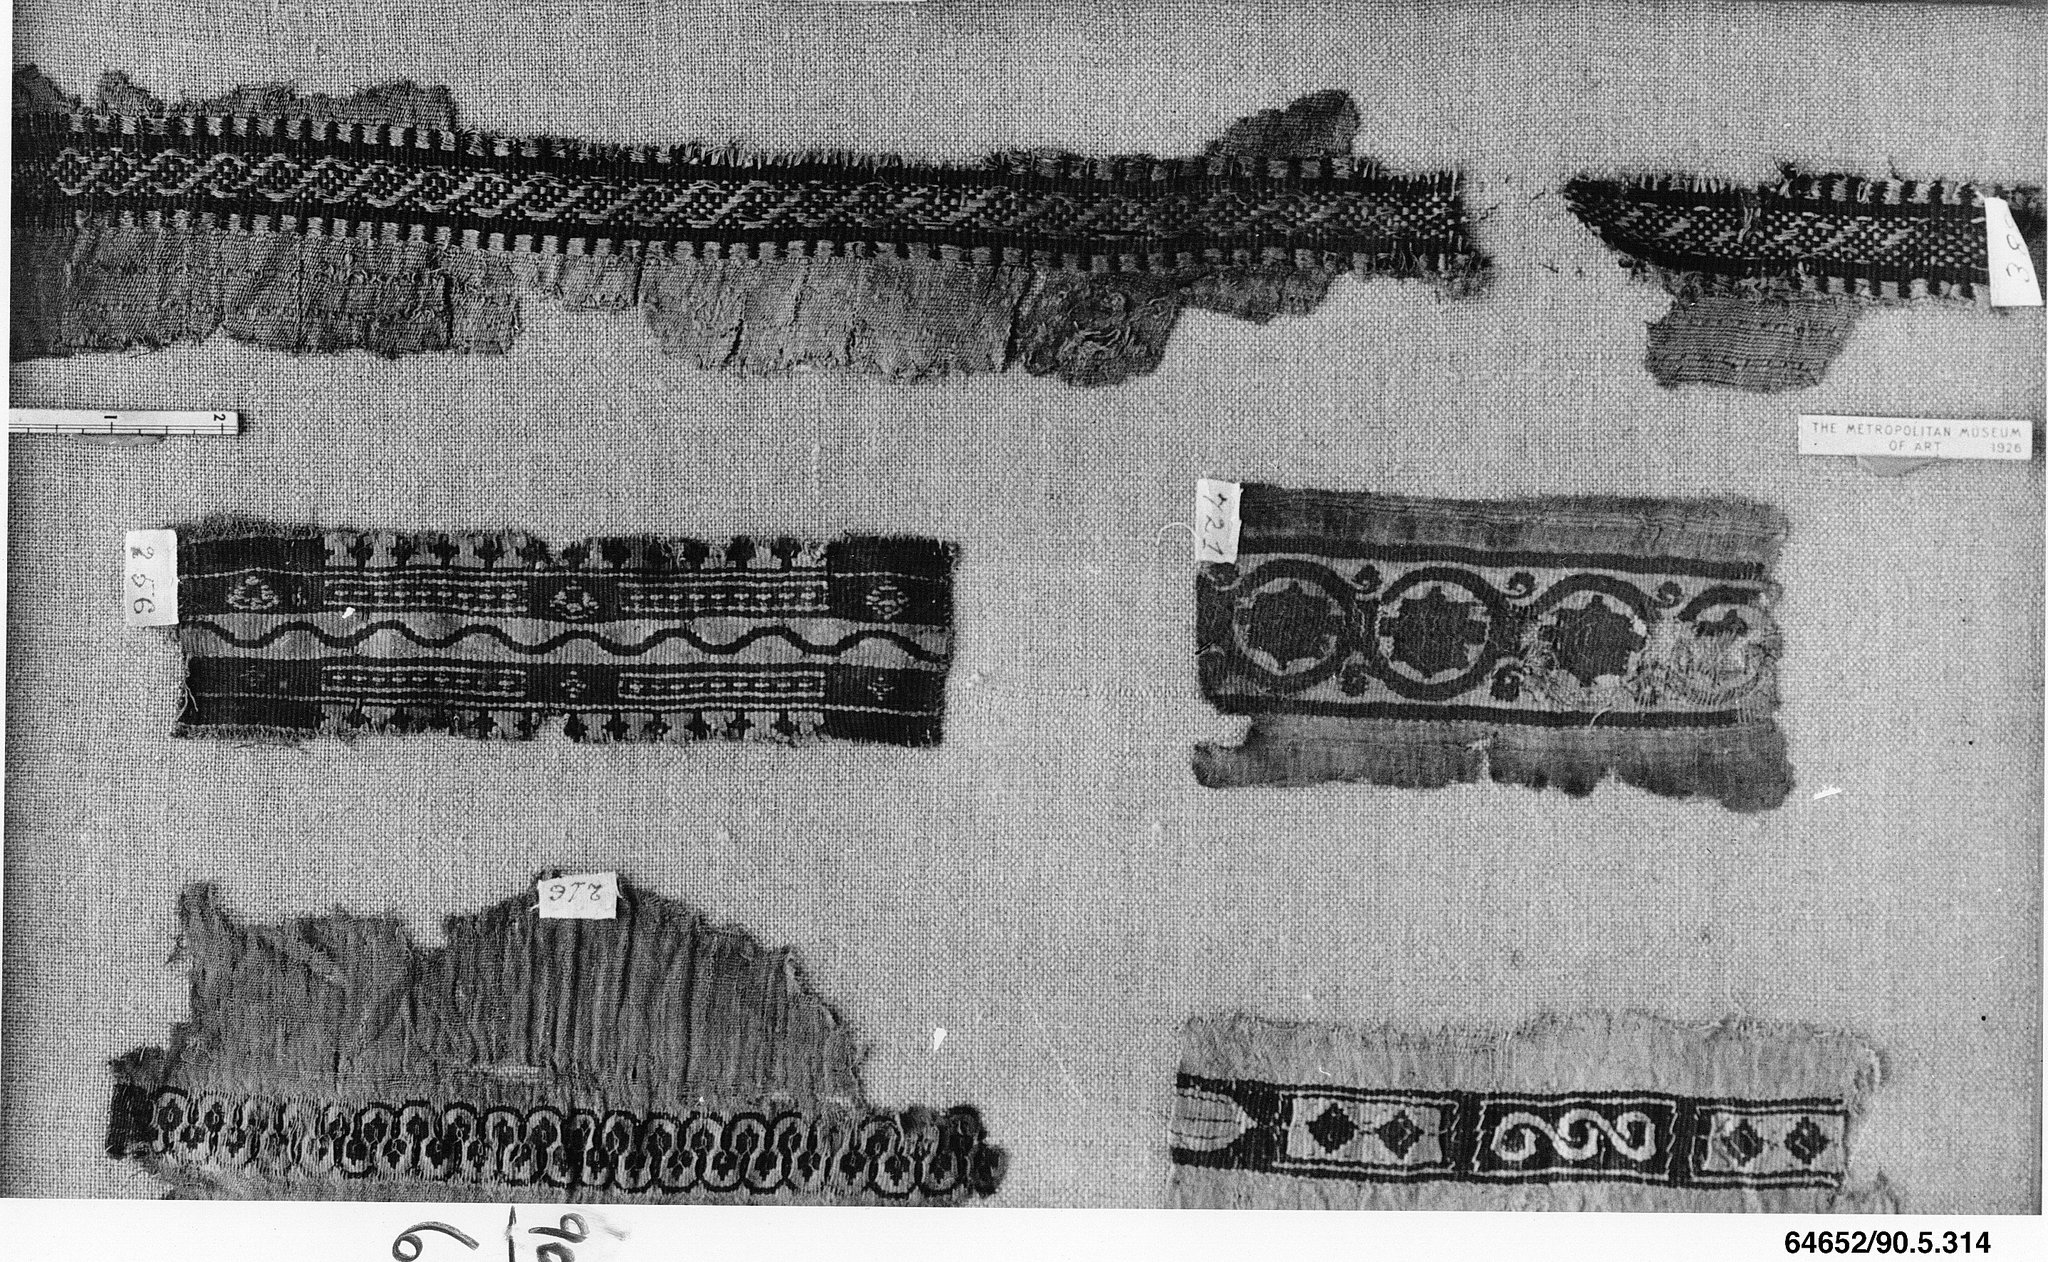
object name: textile fragment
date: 301-500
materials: linen, wool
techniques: weave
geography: egypt